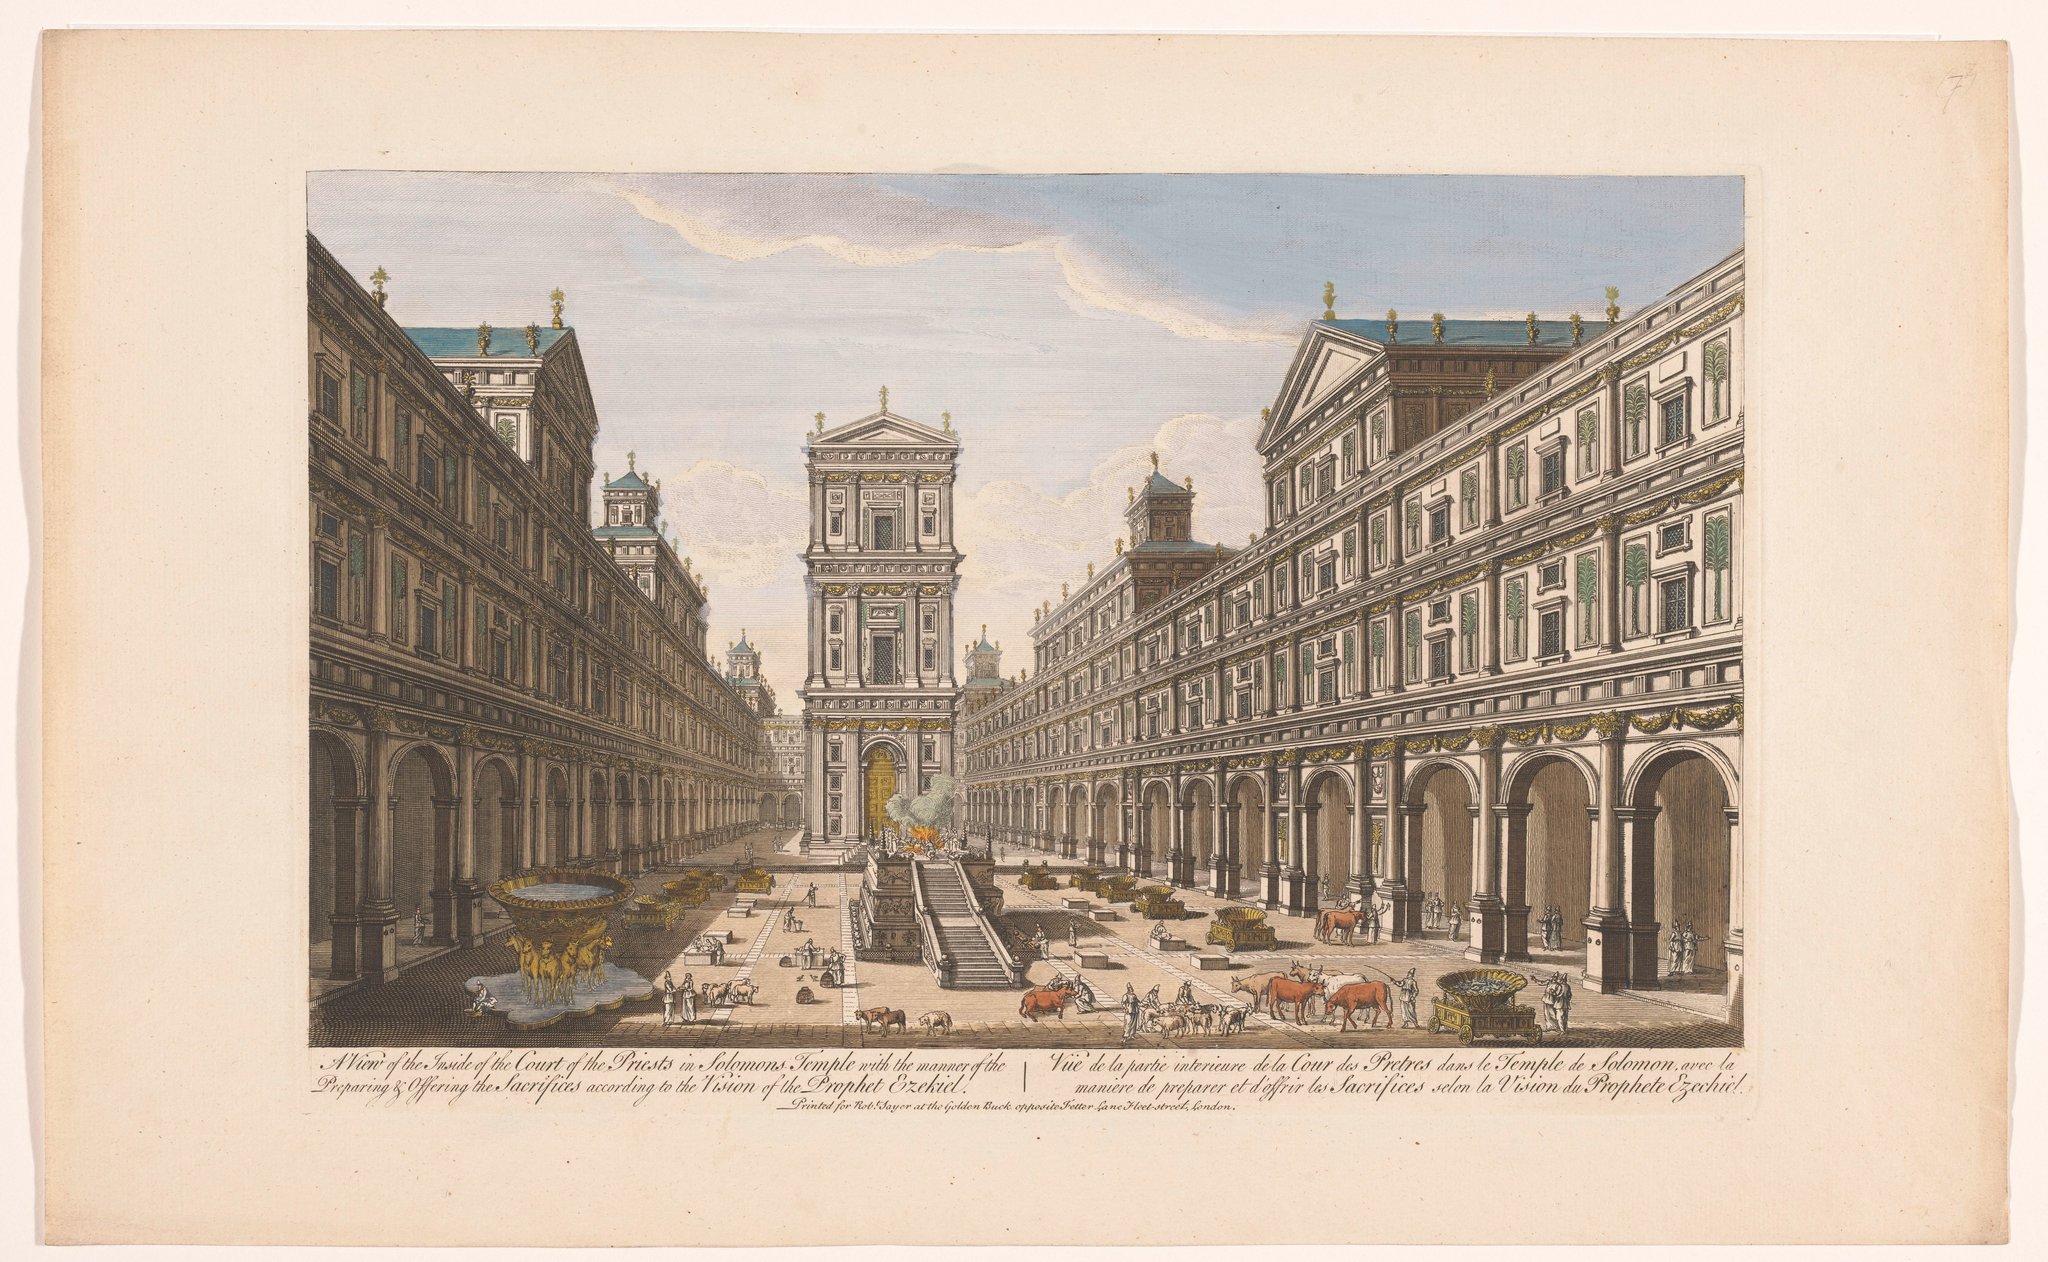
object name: opticaprent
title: Gezicht op de binnenplaats van de Tempel van Salomo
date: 1754-1755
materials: paper, watercolor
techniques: brush, etching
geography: london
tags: temple of solomon (1 kings 5-9; 2 chronicles 2-7)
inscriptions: watermark